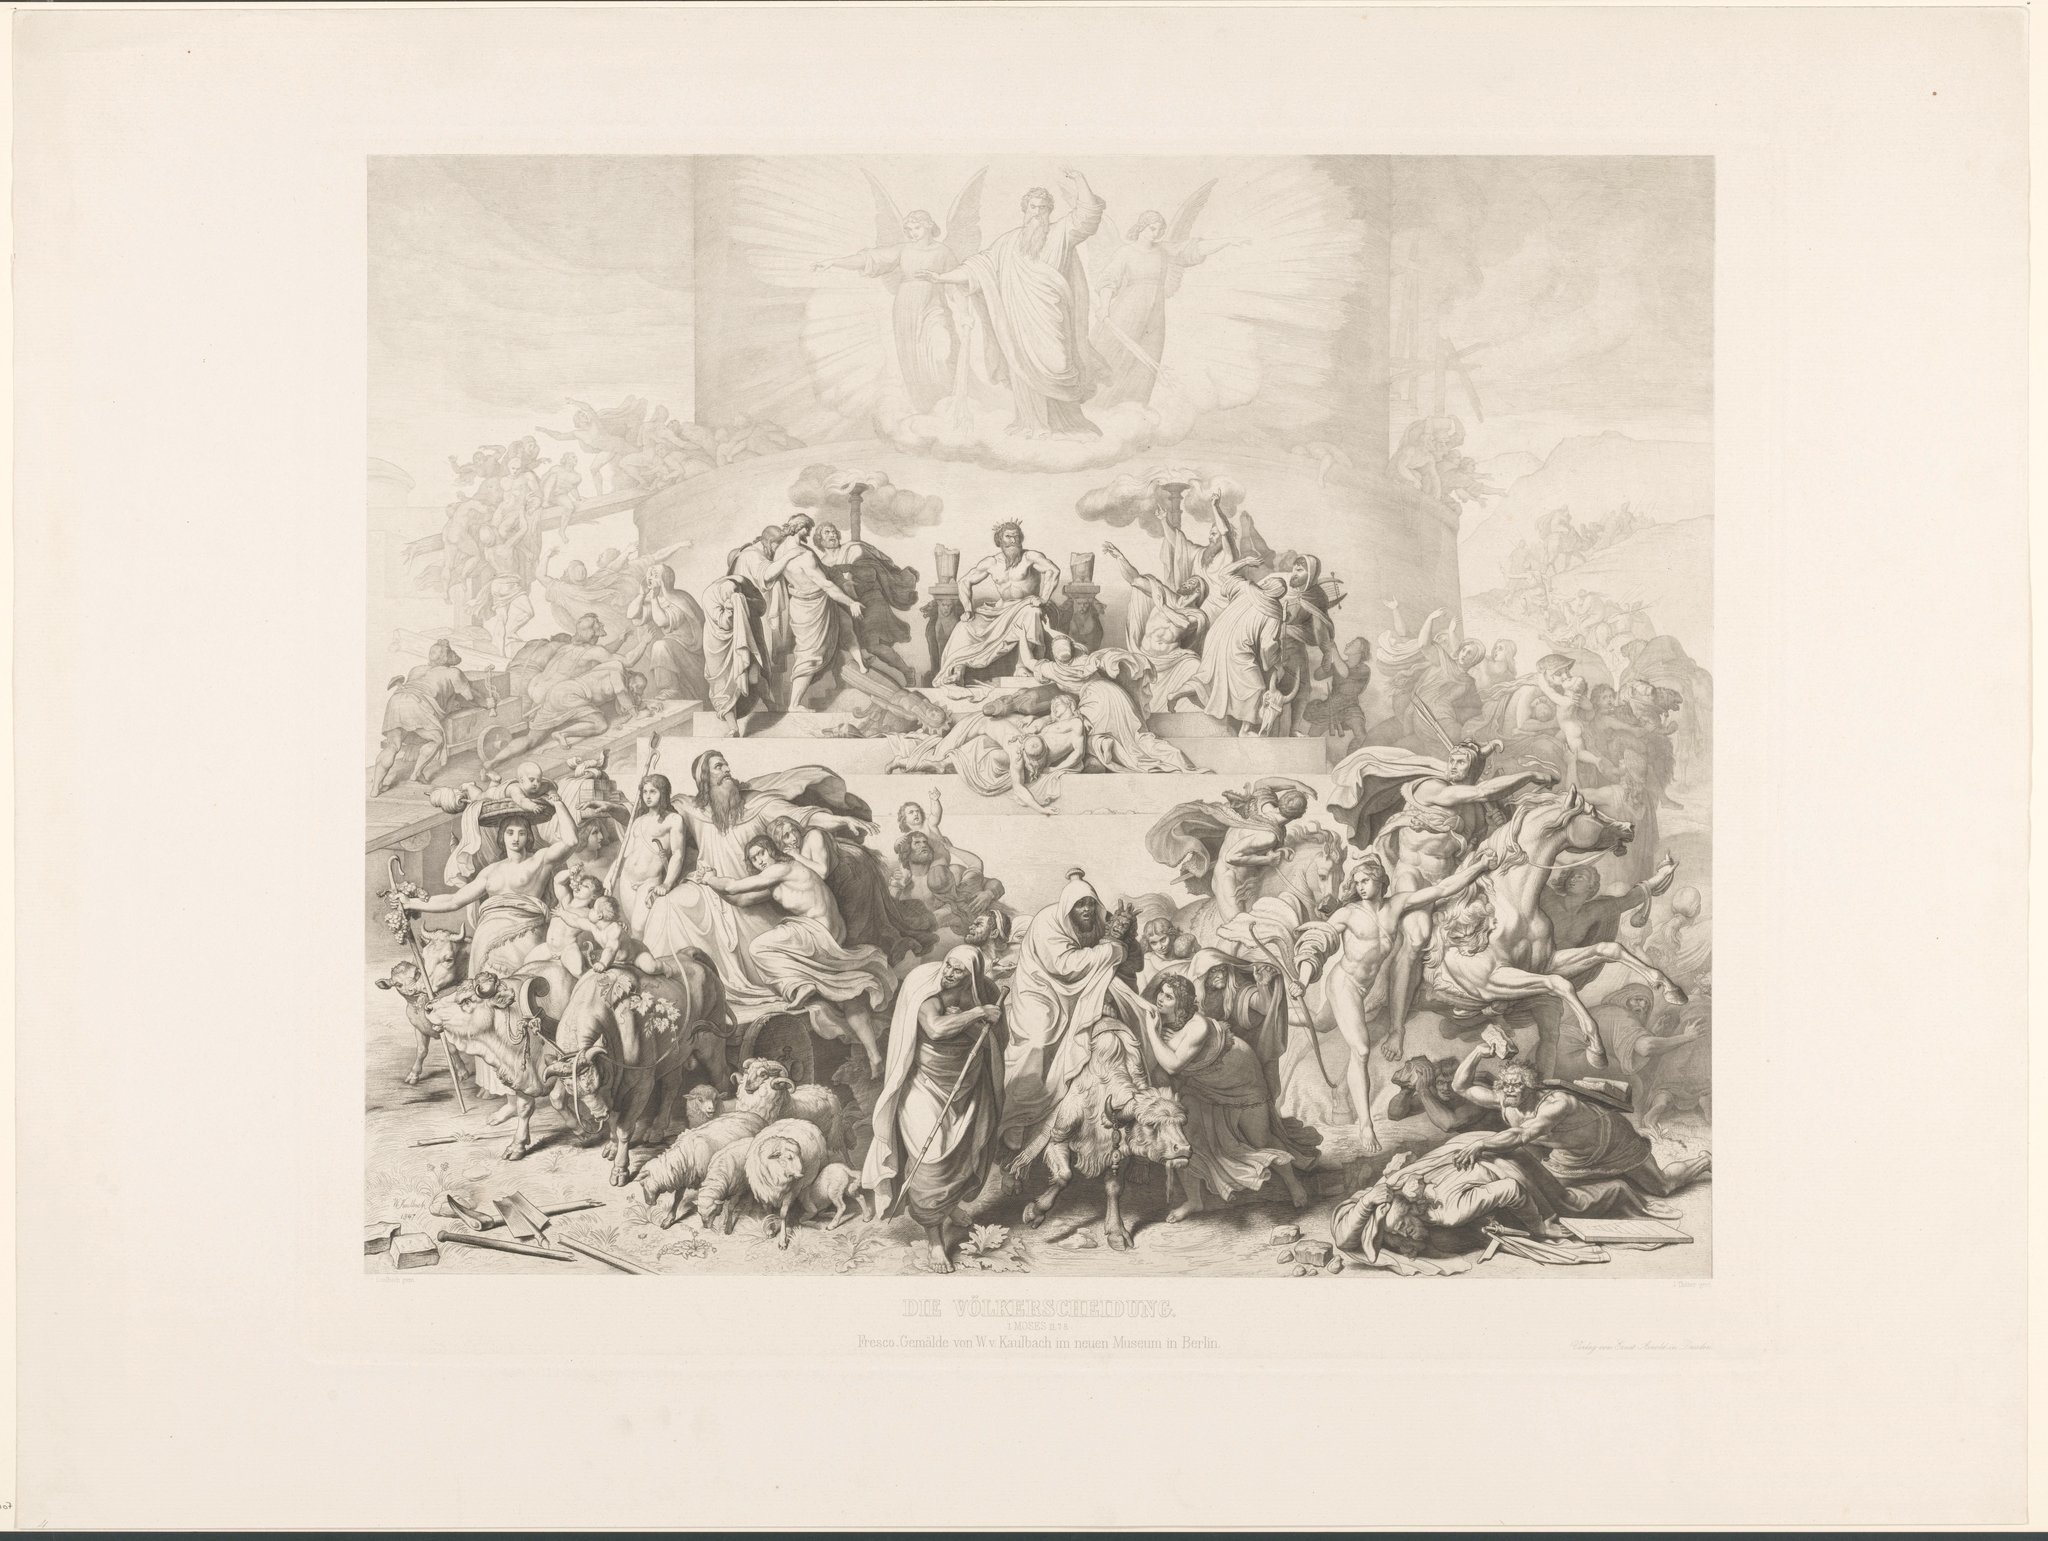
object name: print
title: Gevolgen van de Dood van de eerstgeborenen (Ex.11:7-8)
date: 1814-1870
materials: paper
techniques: engraving, etching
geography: germany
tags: the israelites leave egypt; first movement from rameses to succoth (exodus 12:31 - 13:16), the israelites prepare to leave: the people fill their troughs with unleavened dough, wrap them in clothing and carry them on their shoulders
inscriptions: collector's mark: Lugt 12